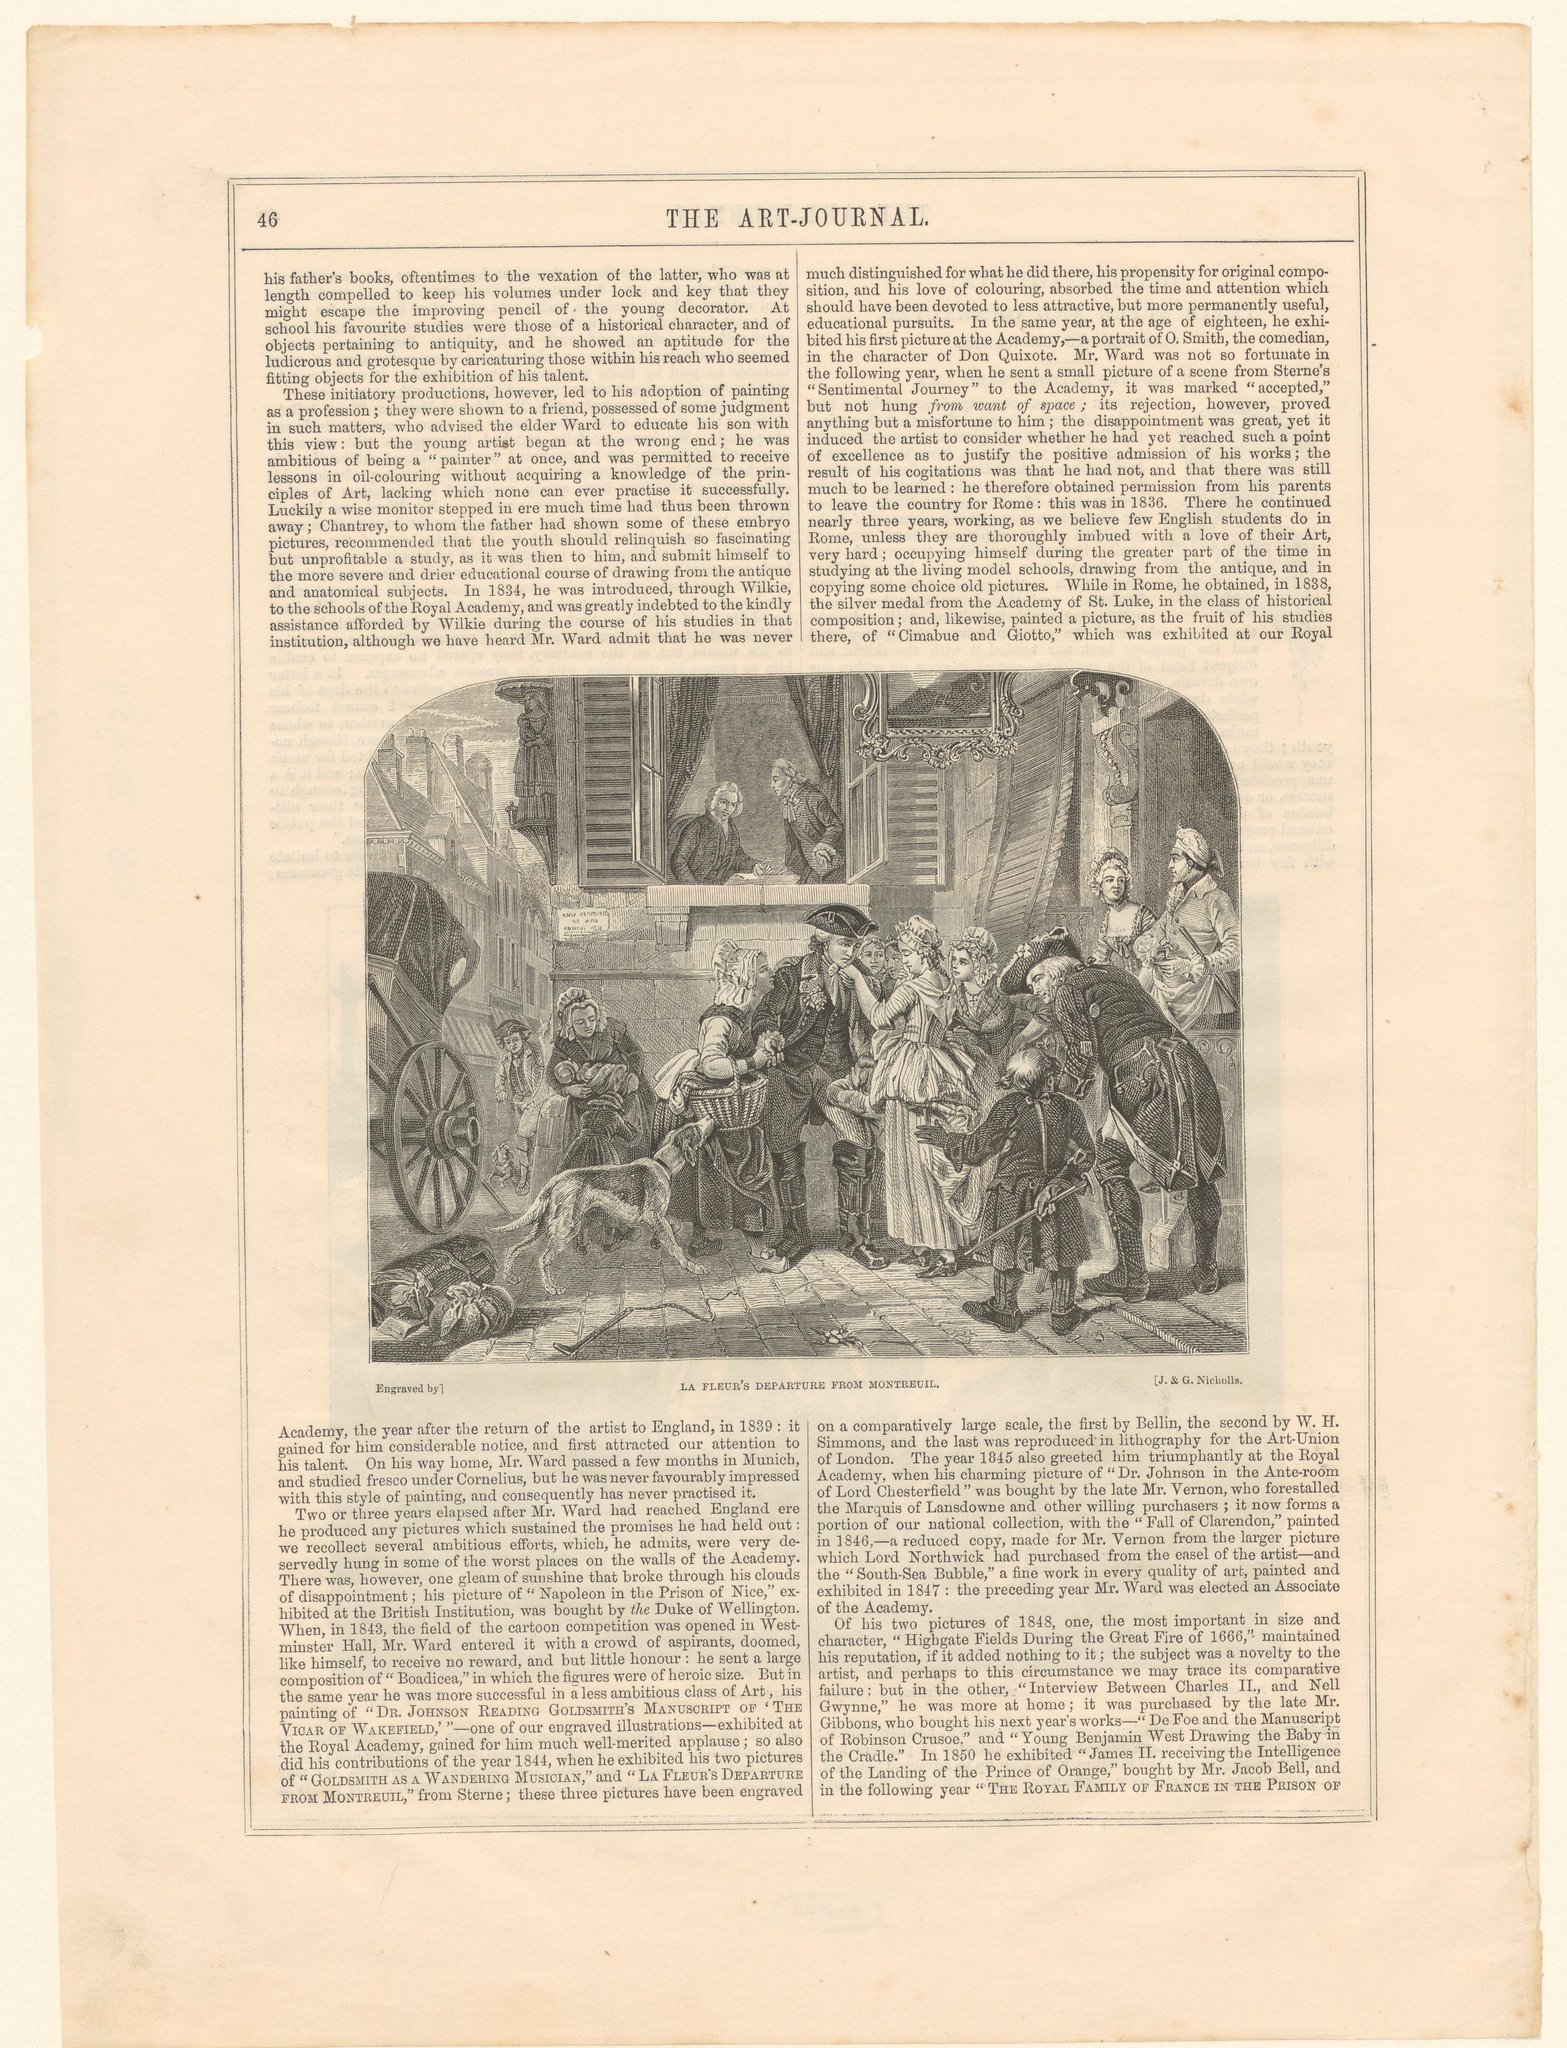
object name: print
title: The royal family of France in the prison of the Temple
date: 1855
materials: paper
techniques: letterpress printing, engraving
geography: london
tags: family of a ruler, and court, interior of the house, imprisonment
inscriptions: collector's mark: Lugt 2228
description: Prent uit: The Art Journal (1855), 1855, p. 45.